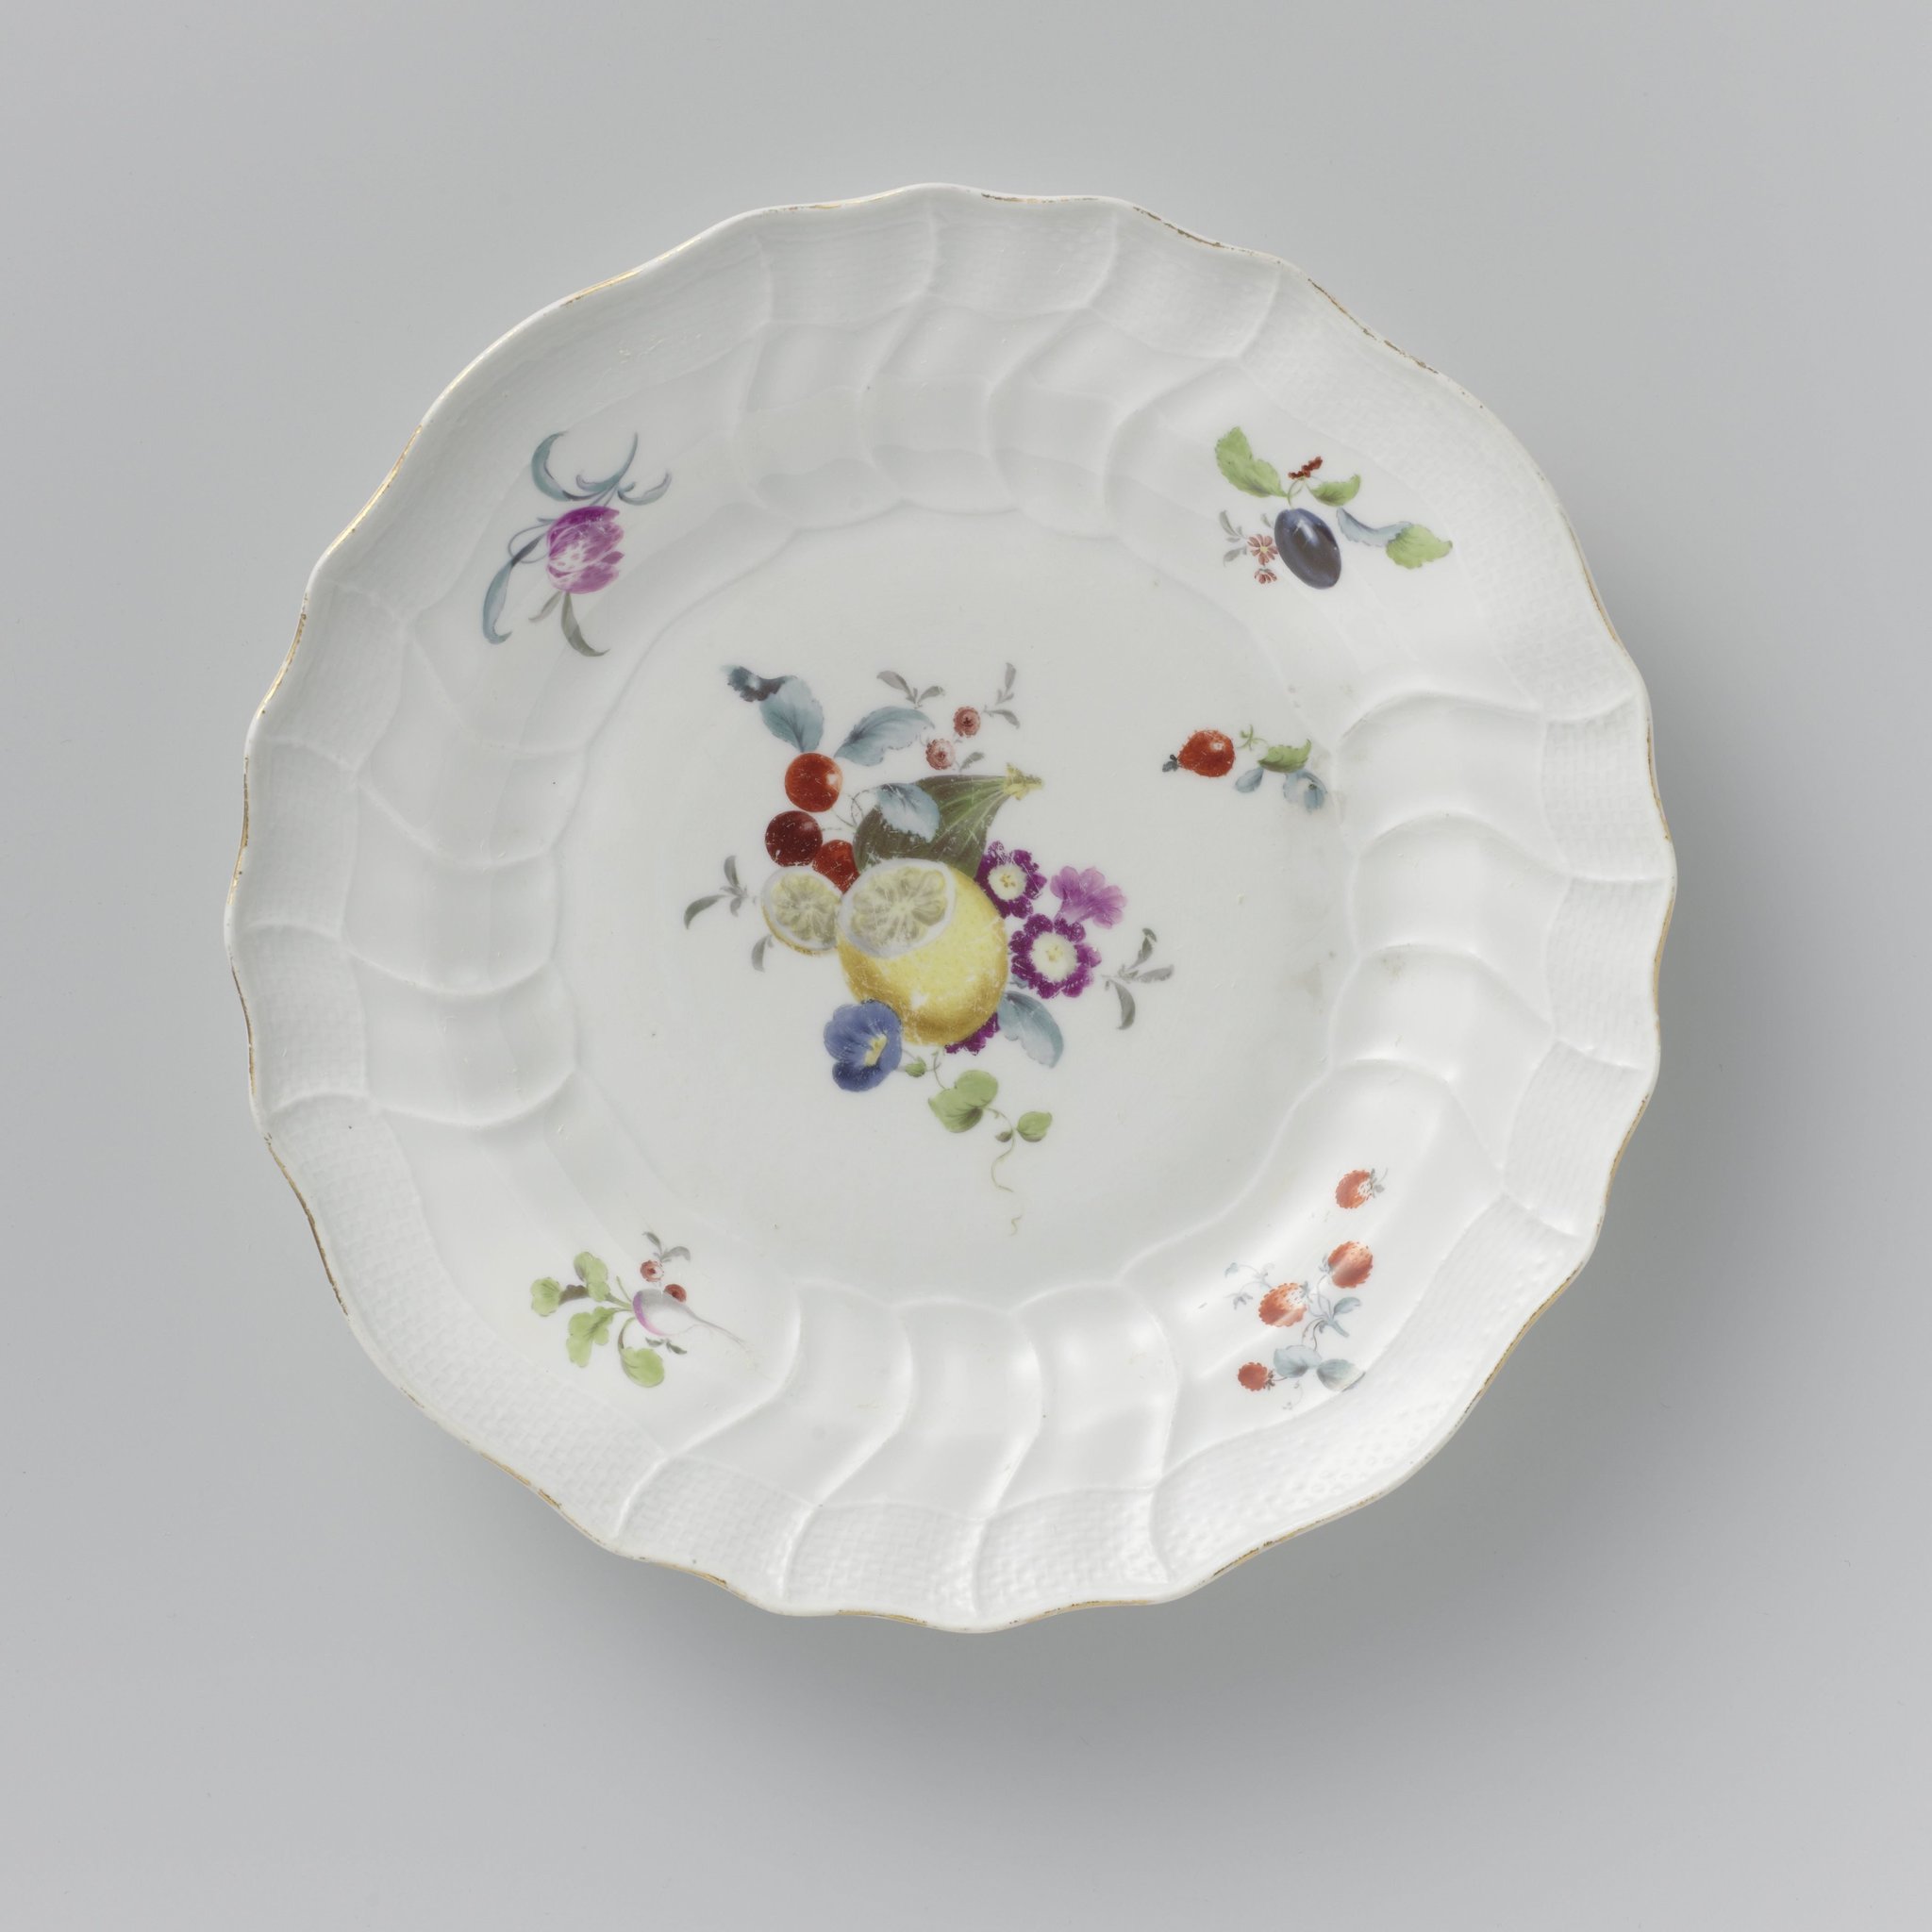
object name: eating drinking utensil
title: Bord, veelkleurig beschilderd met Deutsche Blumen, insekten en vruchten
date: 1750-1760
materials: porcelain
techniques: painted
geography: meissen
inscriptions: factory mark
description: Rond bord van beschilderd porselein. De rand is versierd met het Neuozier-patroon in reliëf. De beschildering bestaat uit Deutsche Blumen, insekten en vruchten. Het bord is gemerkt en hoort bij een servies (BK-17474-1 t/m BK-17474-253).